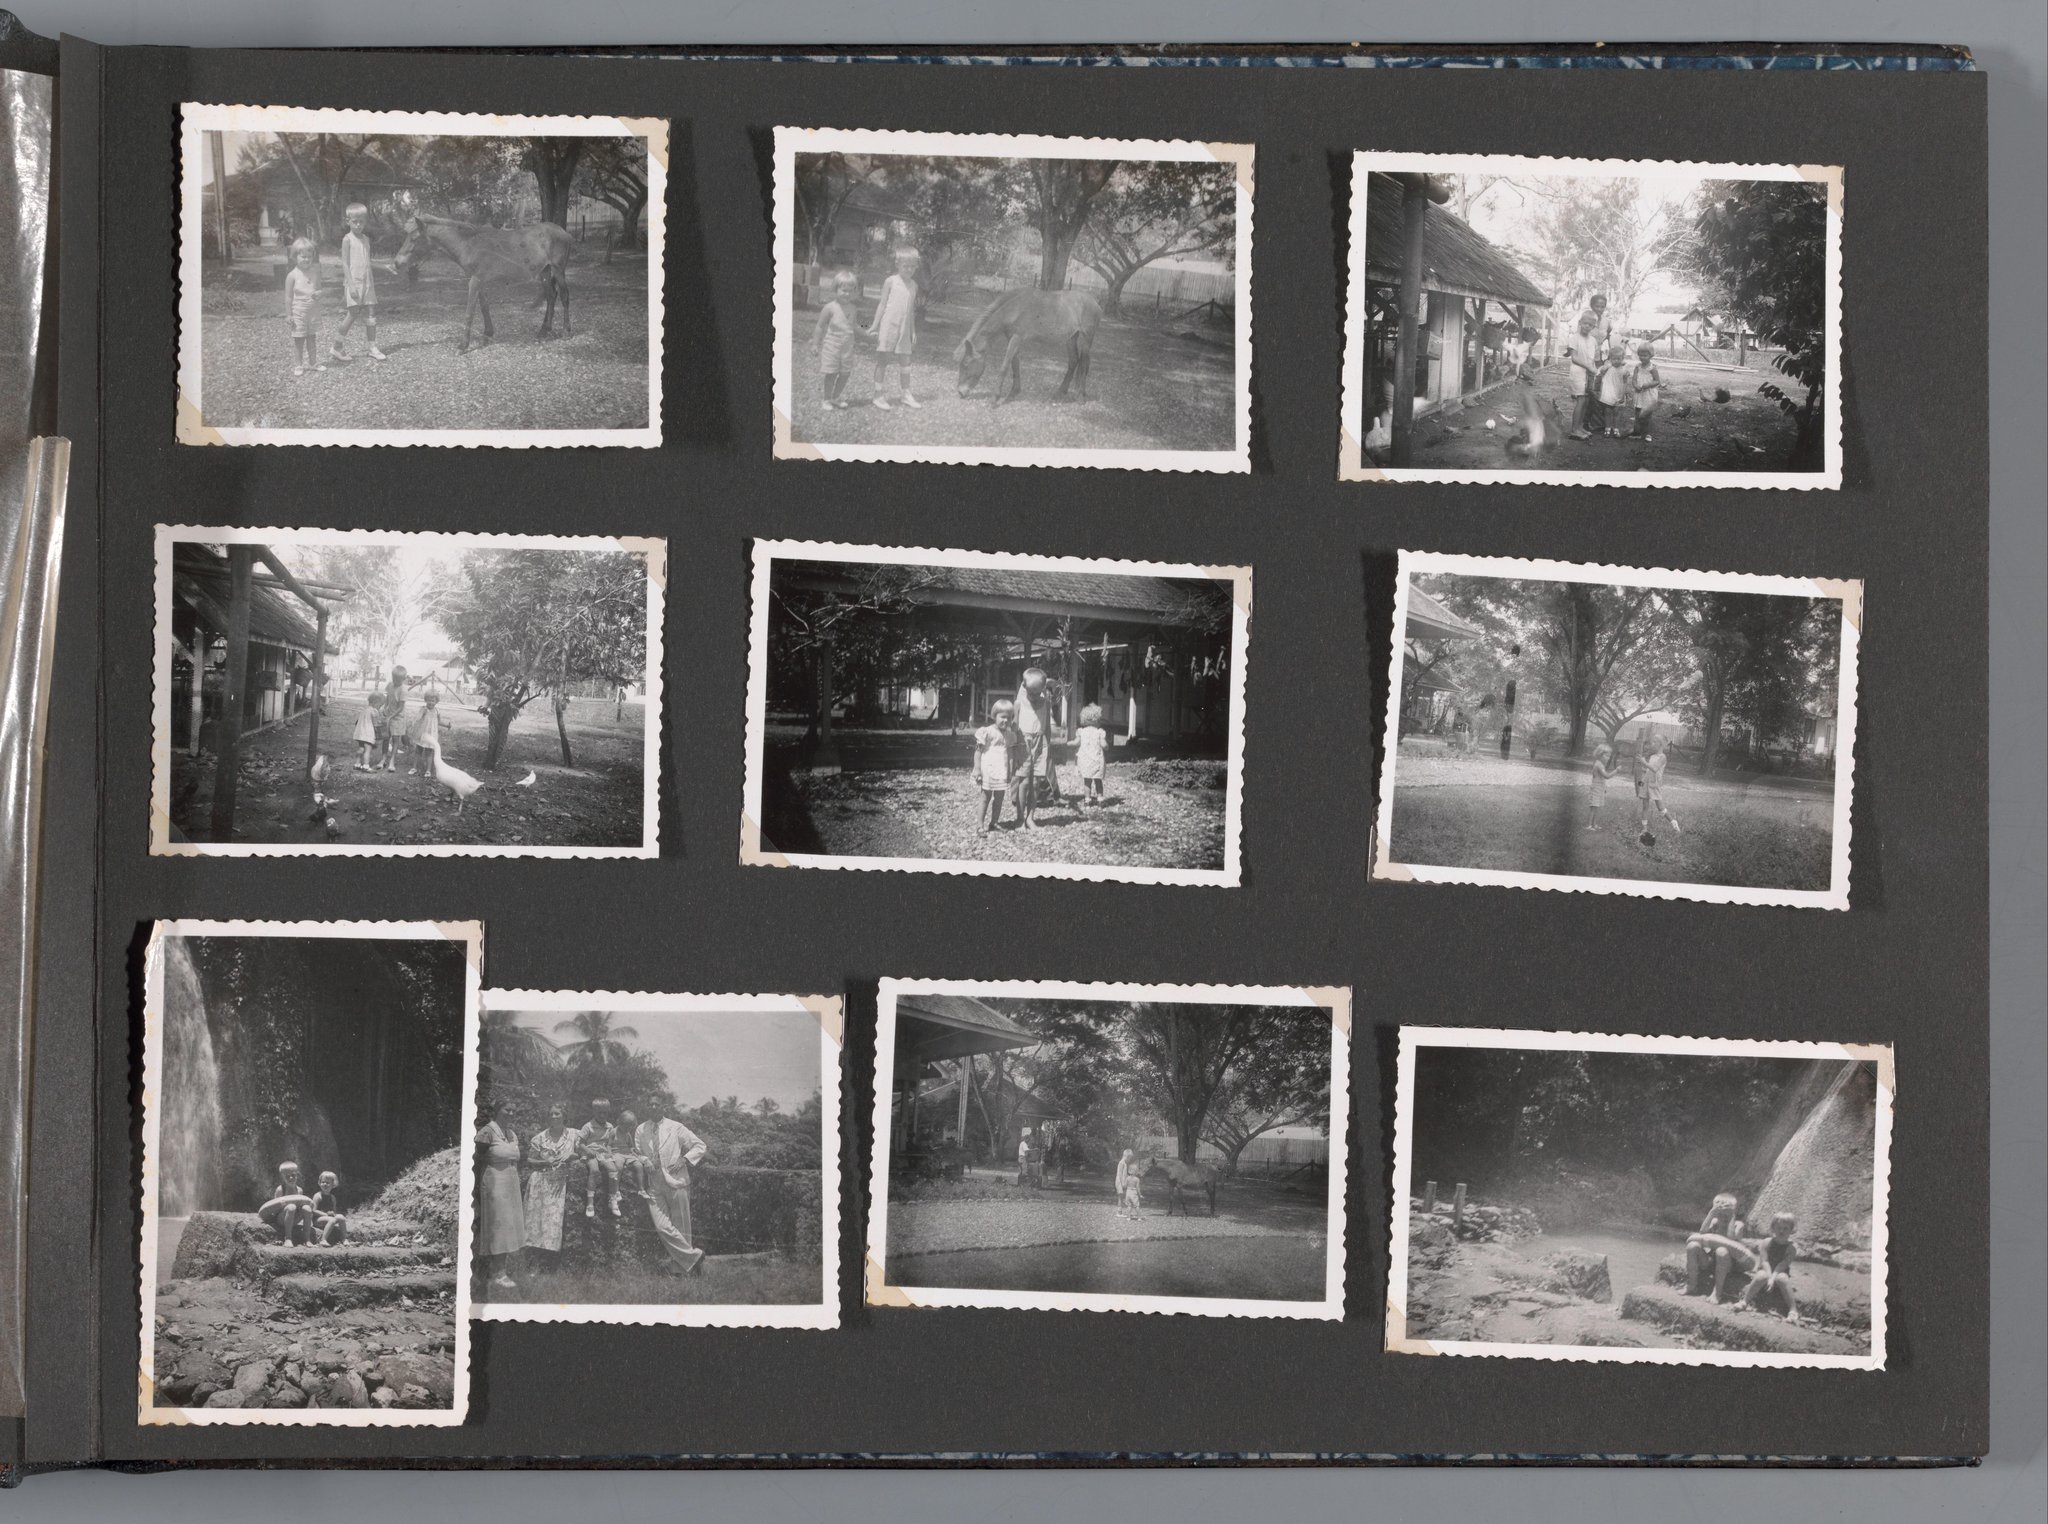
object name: album leaf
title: Kinderen in de tuin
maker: Anonymous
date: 1938-1939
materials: cardboard, photographic support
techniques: gelatin silver print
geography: celebes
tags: jet vonk, fowl (cock, hen, chicken, etc.), family life at home, horse, backyard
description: Albumblad met tien foto's van de kinderen met de paarden, kippen en kalkoenen, en spelend in de tuin. Onderdeel van het familiealbum van Jet Vonk uit Celebes.